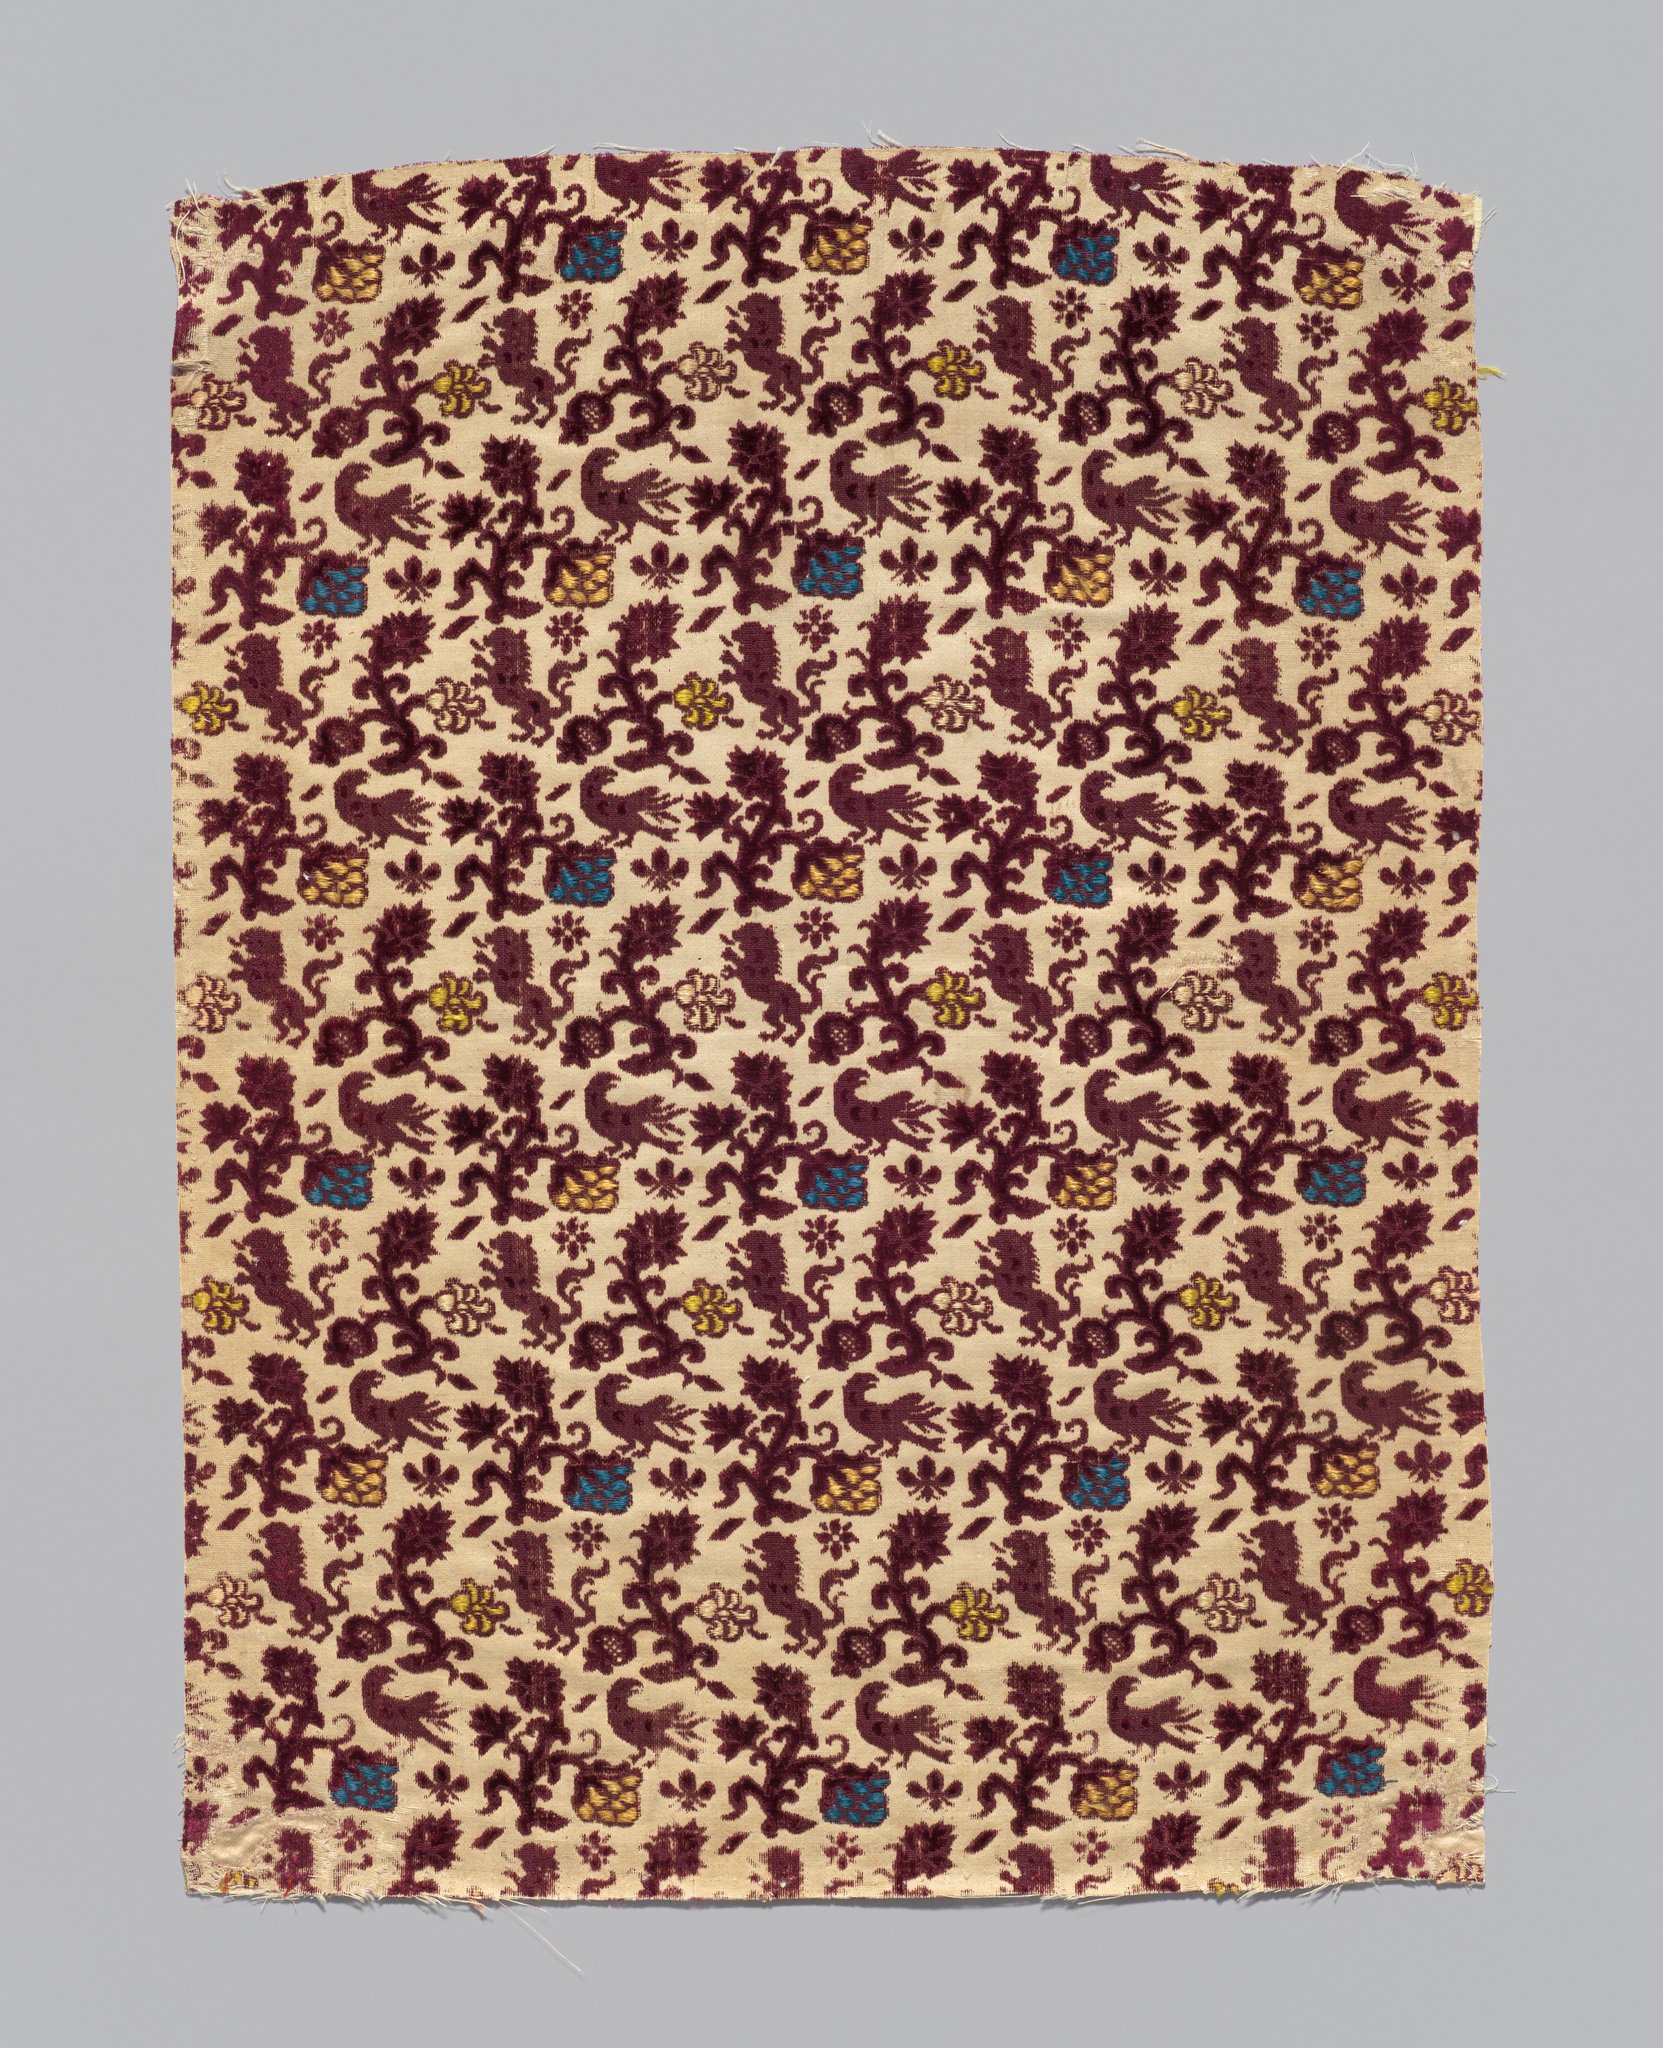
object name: piece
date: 1567-1633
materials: silk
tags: birds,lions